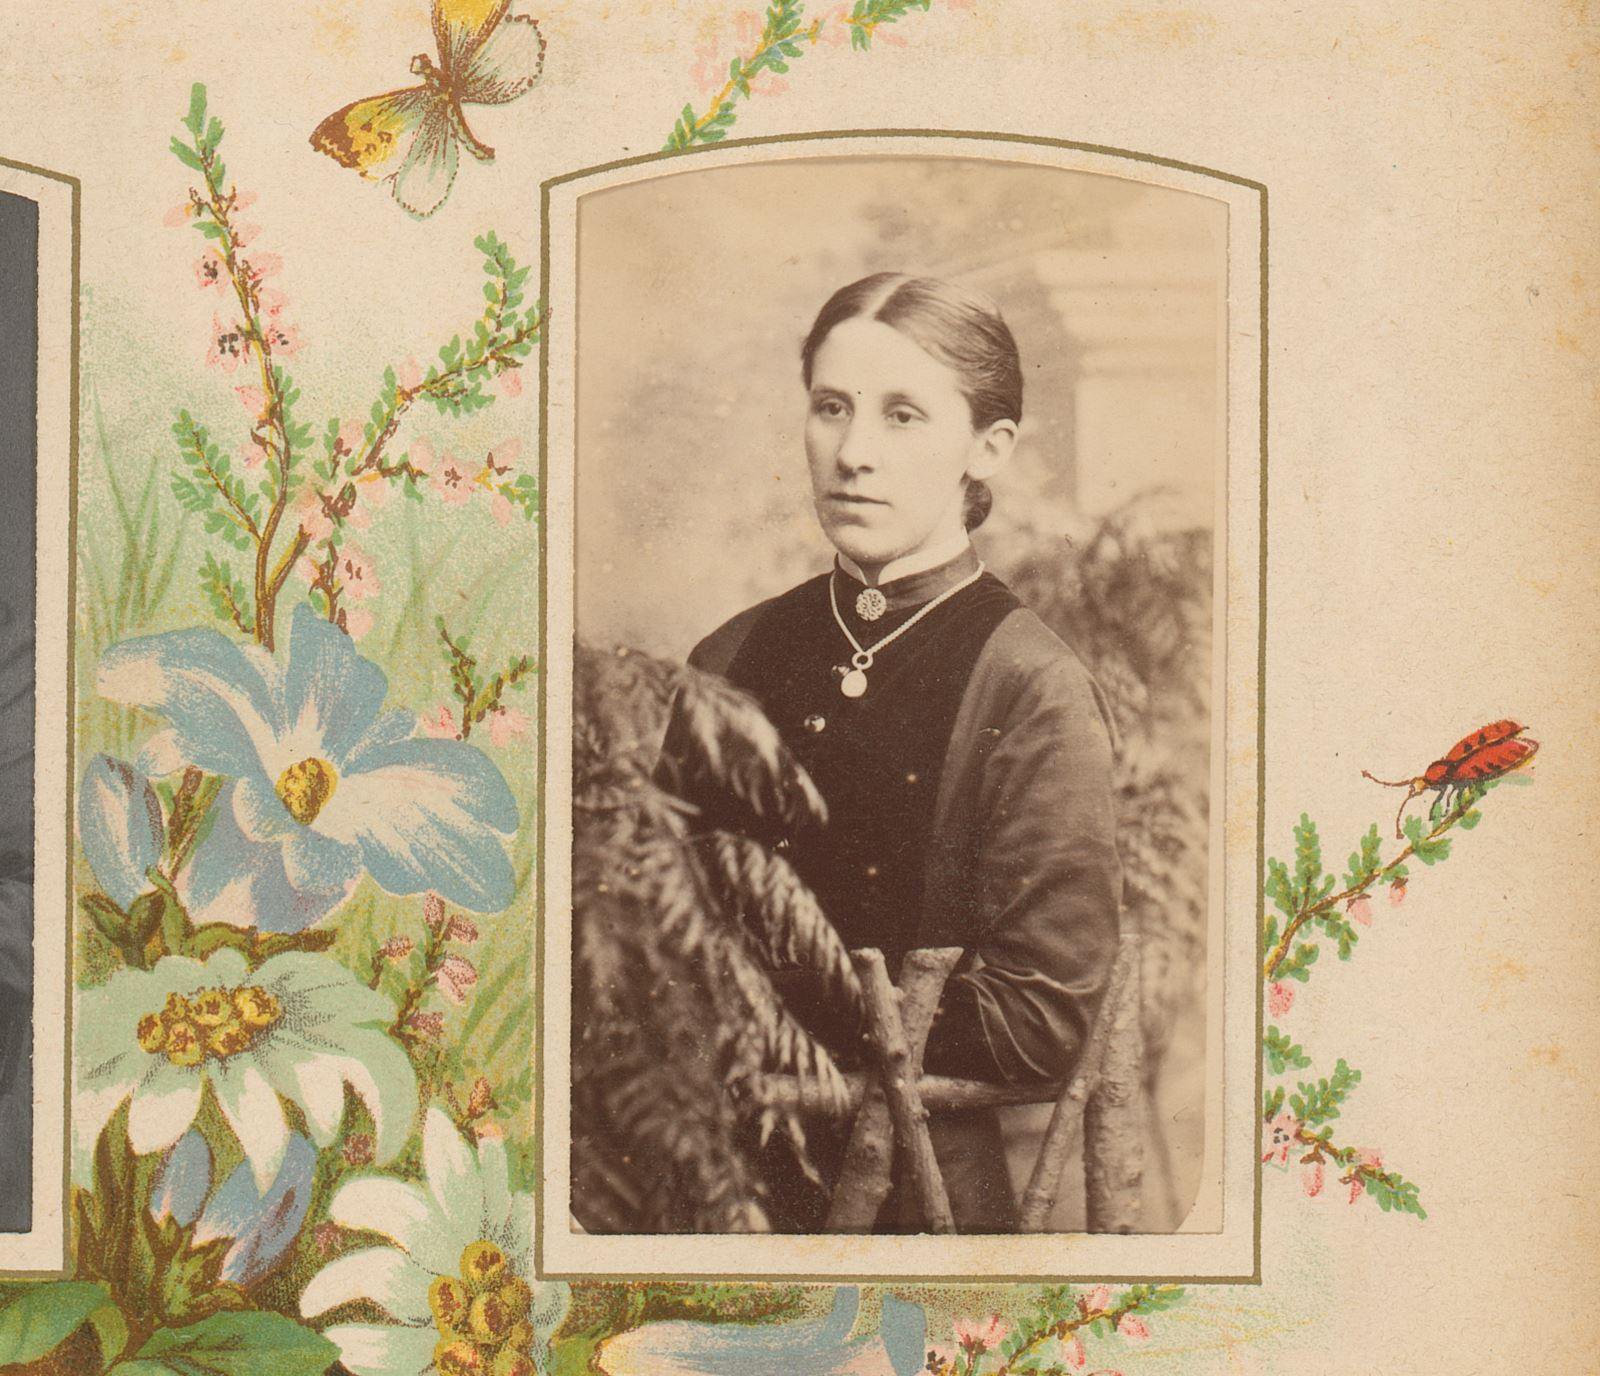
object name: carte de visite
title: Portret van een jonge vrouw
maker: a. james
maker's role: fotograaf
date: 1860-1900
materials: cardboard, photographic support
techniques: albumen print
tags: adolescent, young woman, maiden, historical persons, necklace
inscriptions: inscription: ‘From the/ Photographic/ Studio/ of/ A. James/ Ramsgate House/ Louth/ near the station/ (...)’